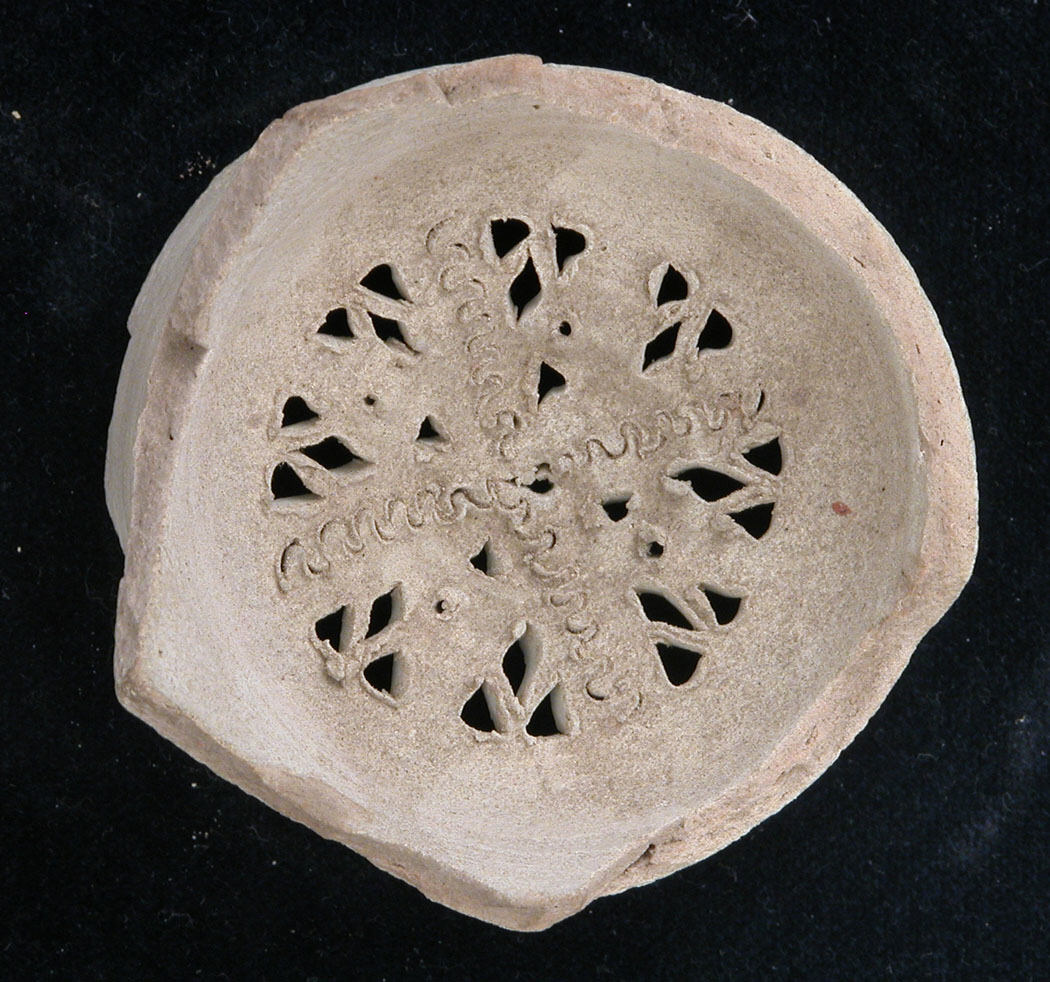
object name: water filter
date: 901-1200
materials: earthenware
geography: egypt